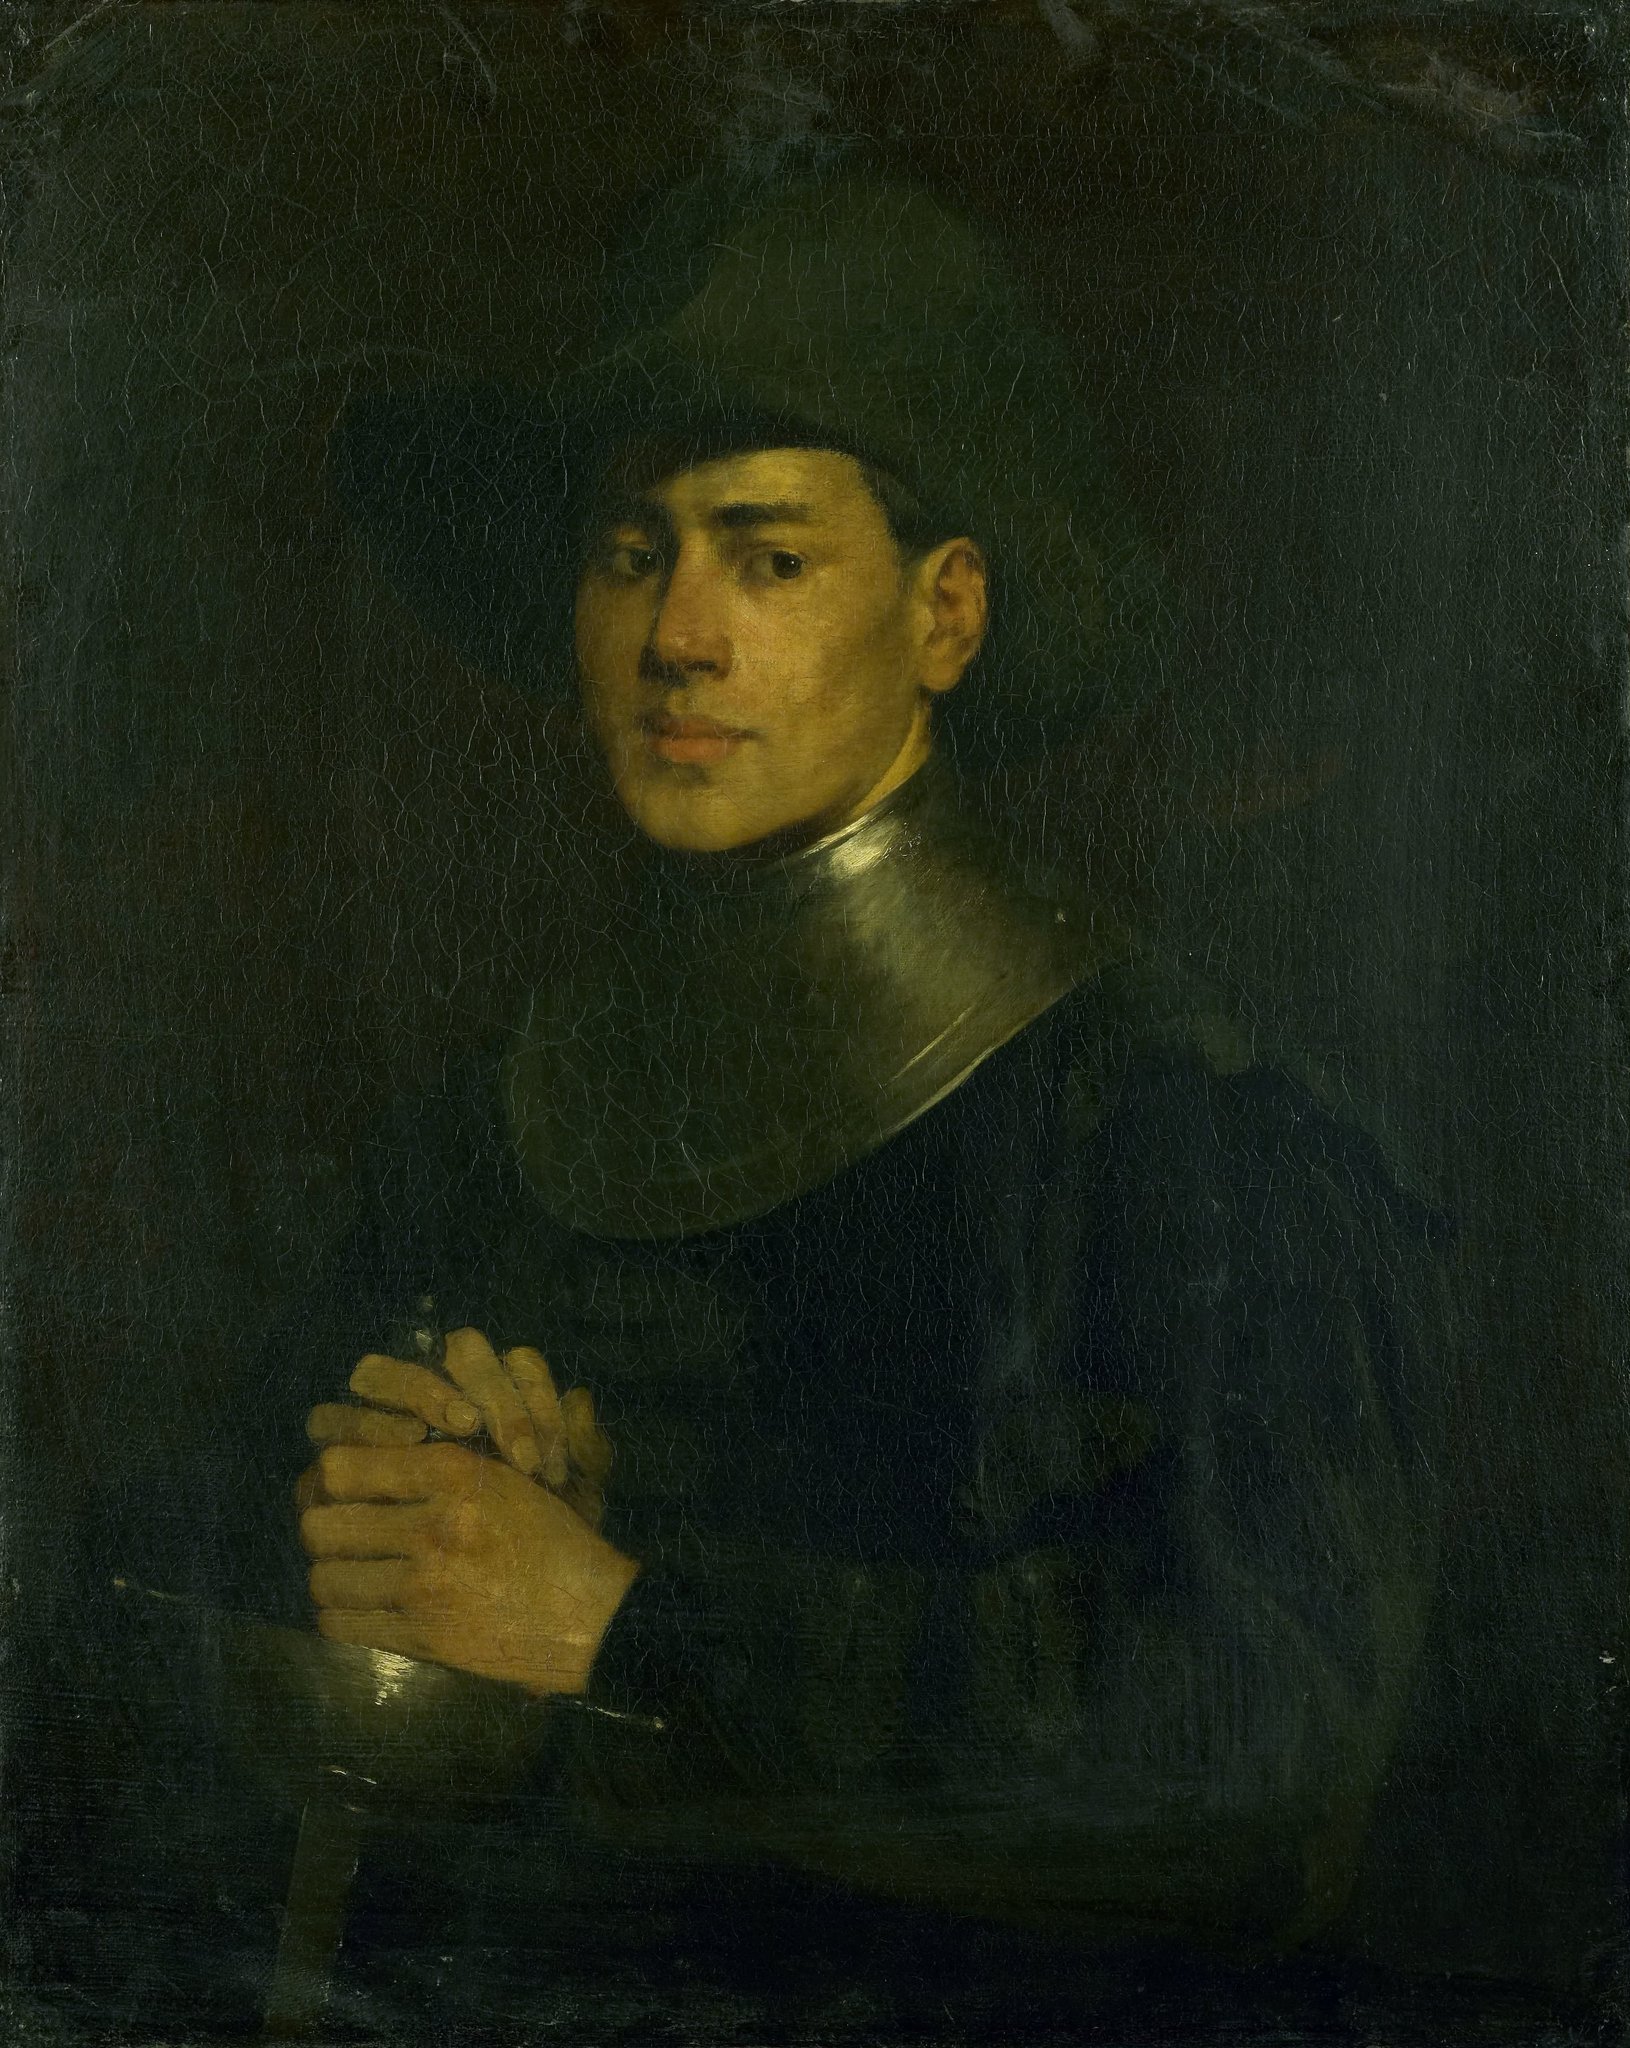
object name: painting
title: De cavalier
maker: louis mettling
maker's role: painter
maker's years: 1847-1904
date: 1870-1900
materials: canvas, oil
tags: armour, the soldier; the soldier's life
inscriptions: signature: ‘L. Mettling’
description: De cavalier. Zittende jonge man, ten halven lijve, met halsberg, hoed met brede rand en beide handen op het gevest van een degen.